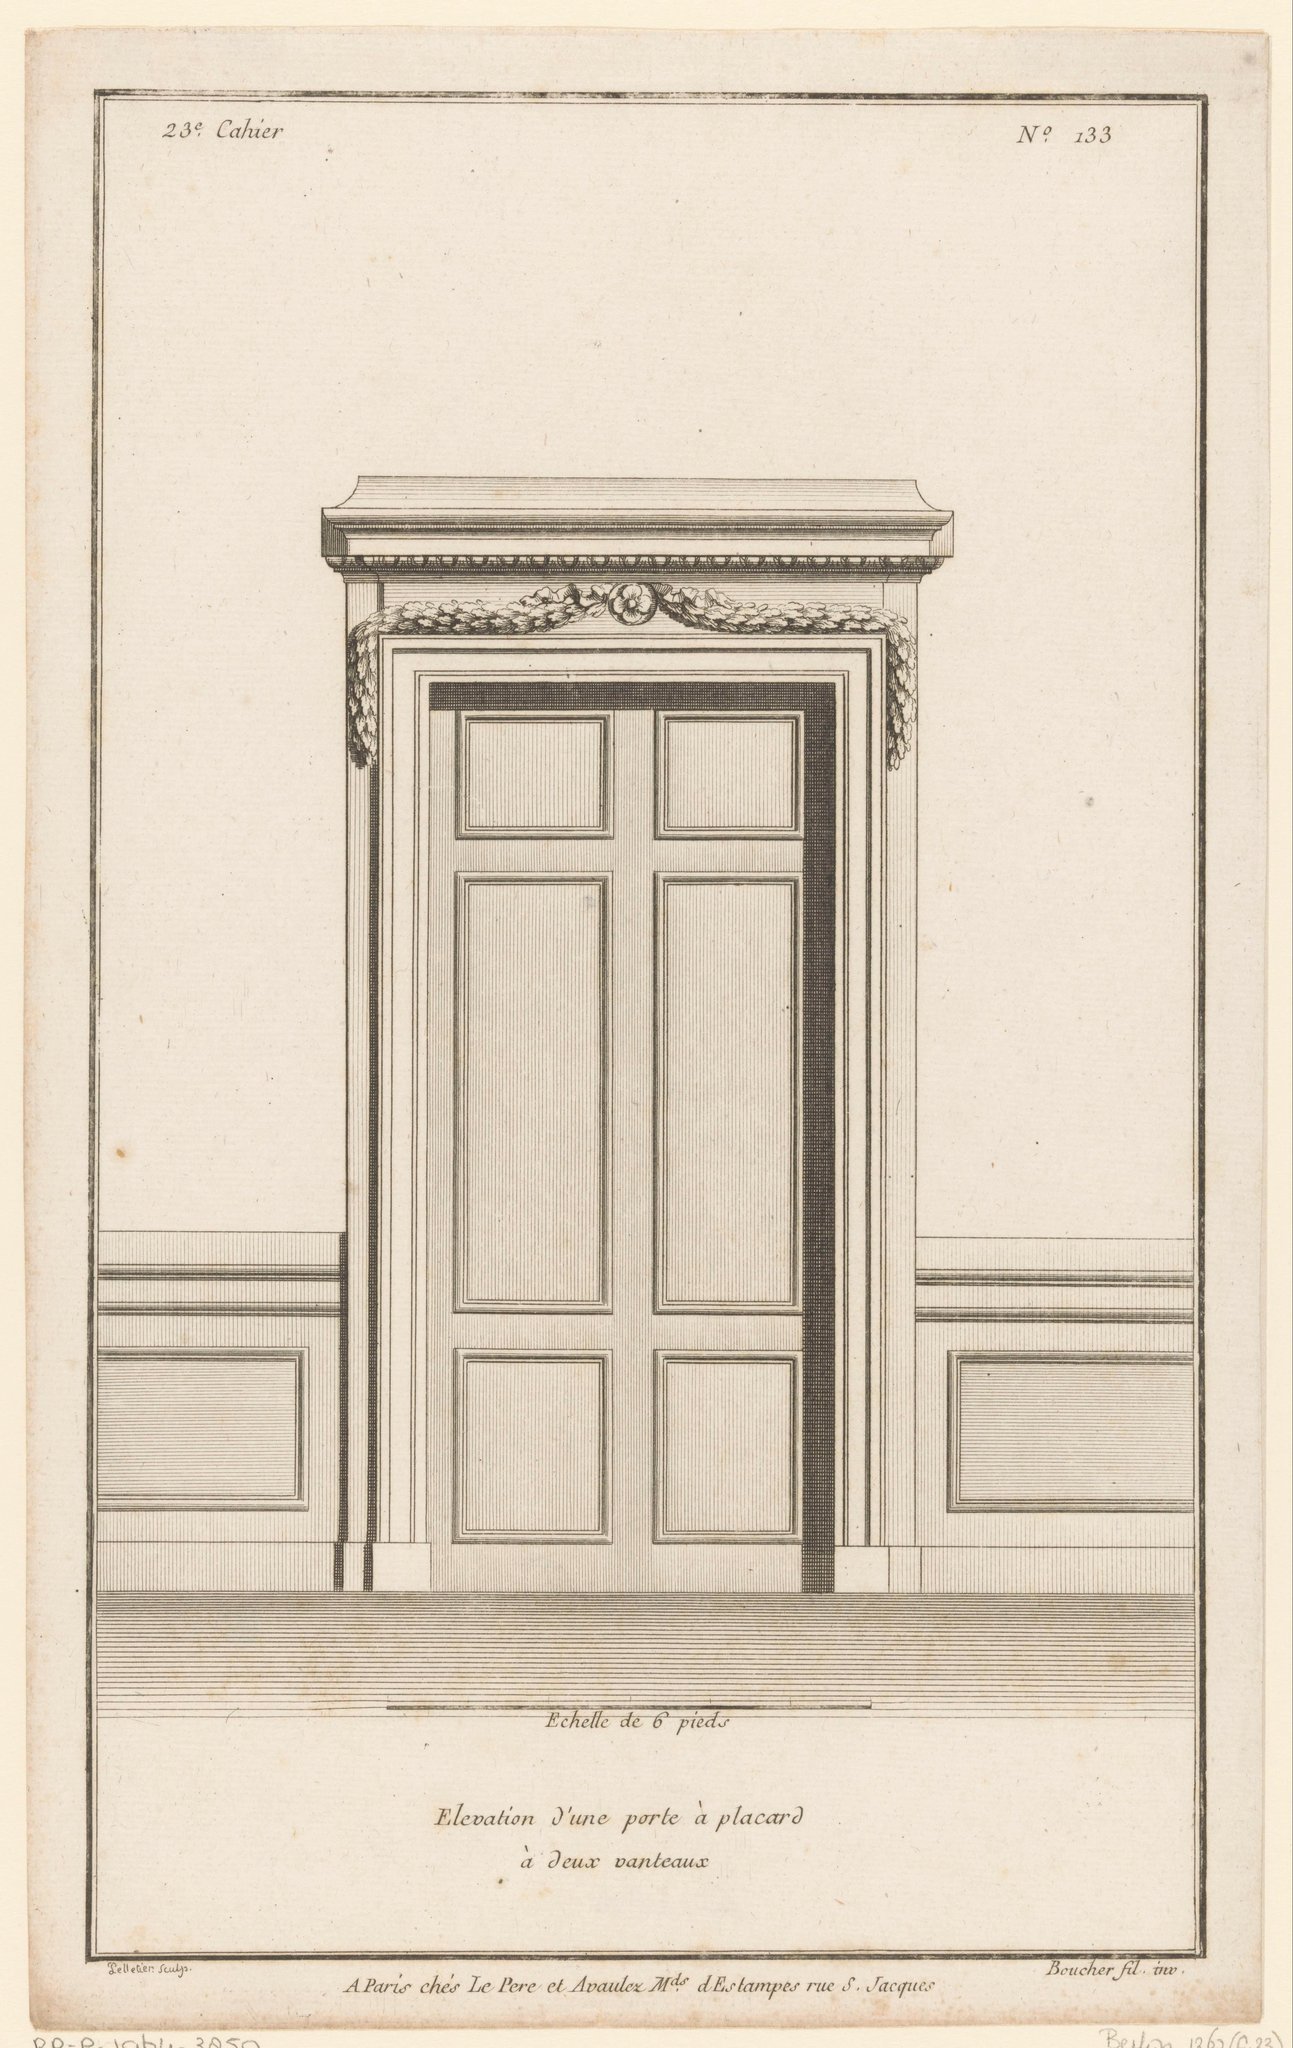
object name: ornament print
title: Deuren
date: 1772-1779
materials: paper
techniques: engraving, etching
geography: paris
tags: door, ornament ~ festoon, garland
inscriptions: collector's mark: Lugt 2760, collector's mark: Lugt 2228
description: Een deur met panelen en guirlandes. Prentnummer 133.